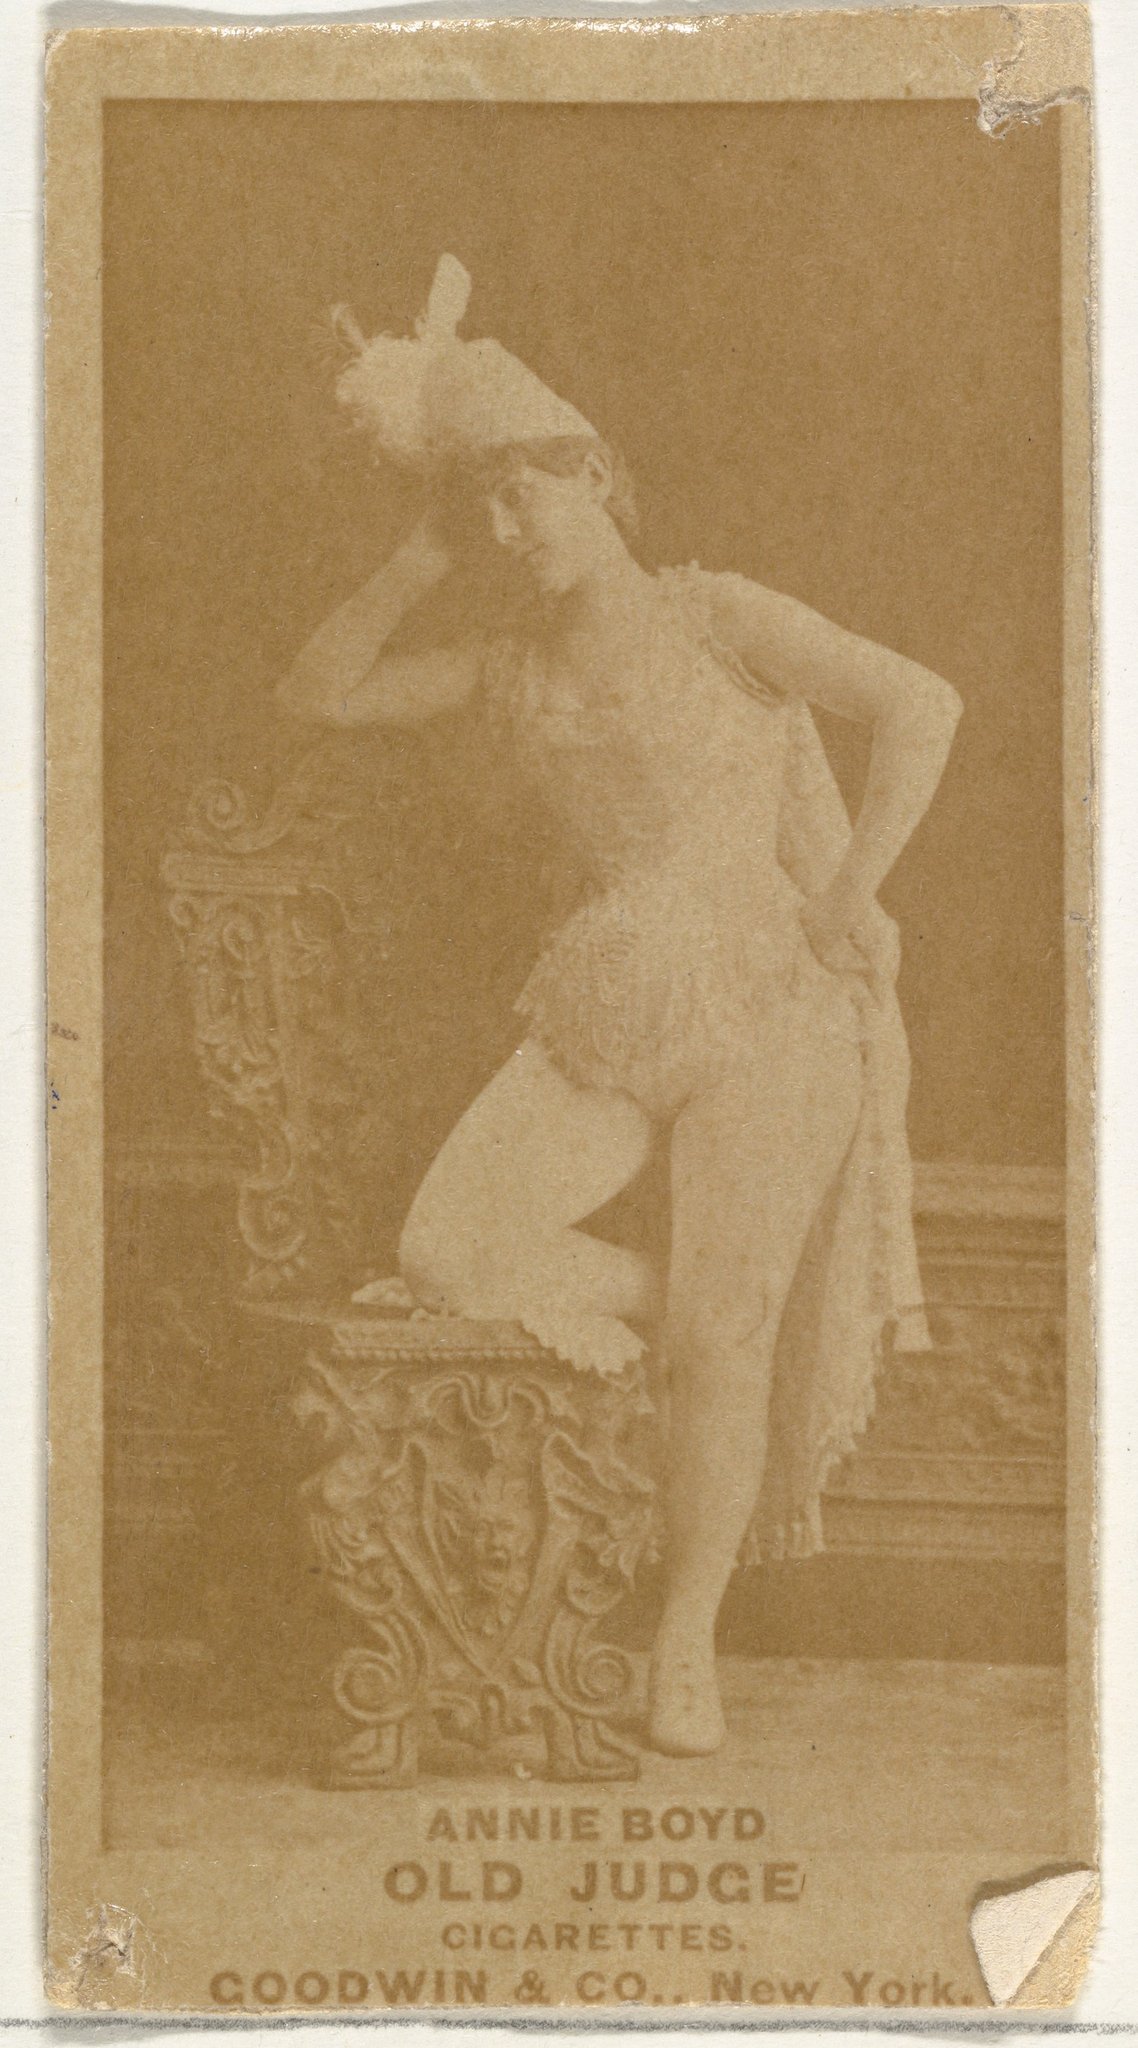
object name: photograph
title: Annie Boyd, from the Actors and Actresses series (N171) for Old Judge Cigarettes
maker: goodwin & company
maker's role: publisher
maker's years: 1850-1950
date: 1886-1890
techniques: albumen silver print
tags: portraits,women,actresses